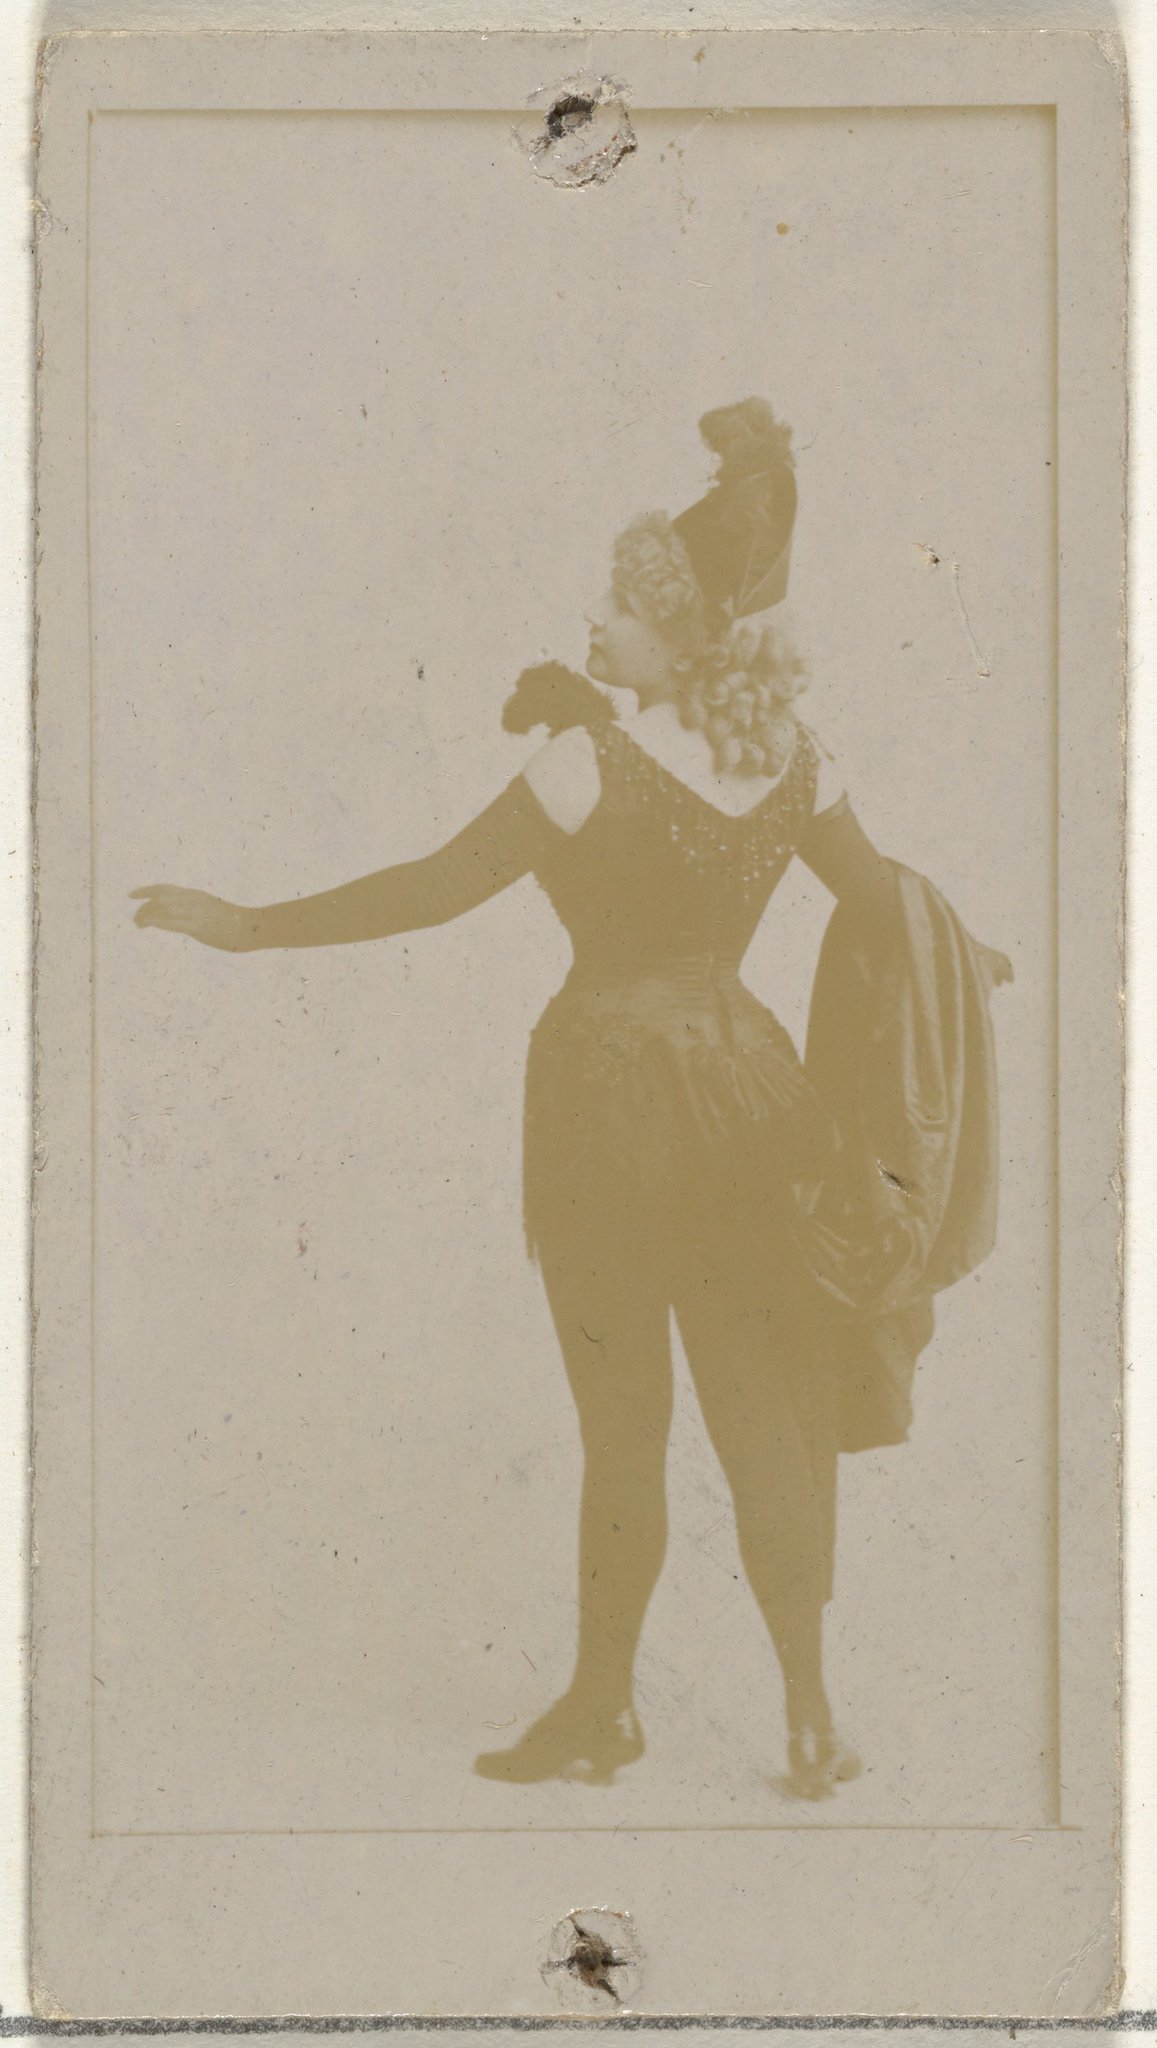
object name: photograph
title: [Actress wearing long gloves and plumed hat], from the Actors and Actresses series (N145-8) issued by Duke Sons & Co. to promote Duke Cigarettes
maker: w. duke, sons & co.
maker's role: publisher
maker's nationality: american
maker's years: 1870-1920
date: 1891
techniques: albumen silver print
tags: women,actresses